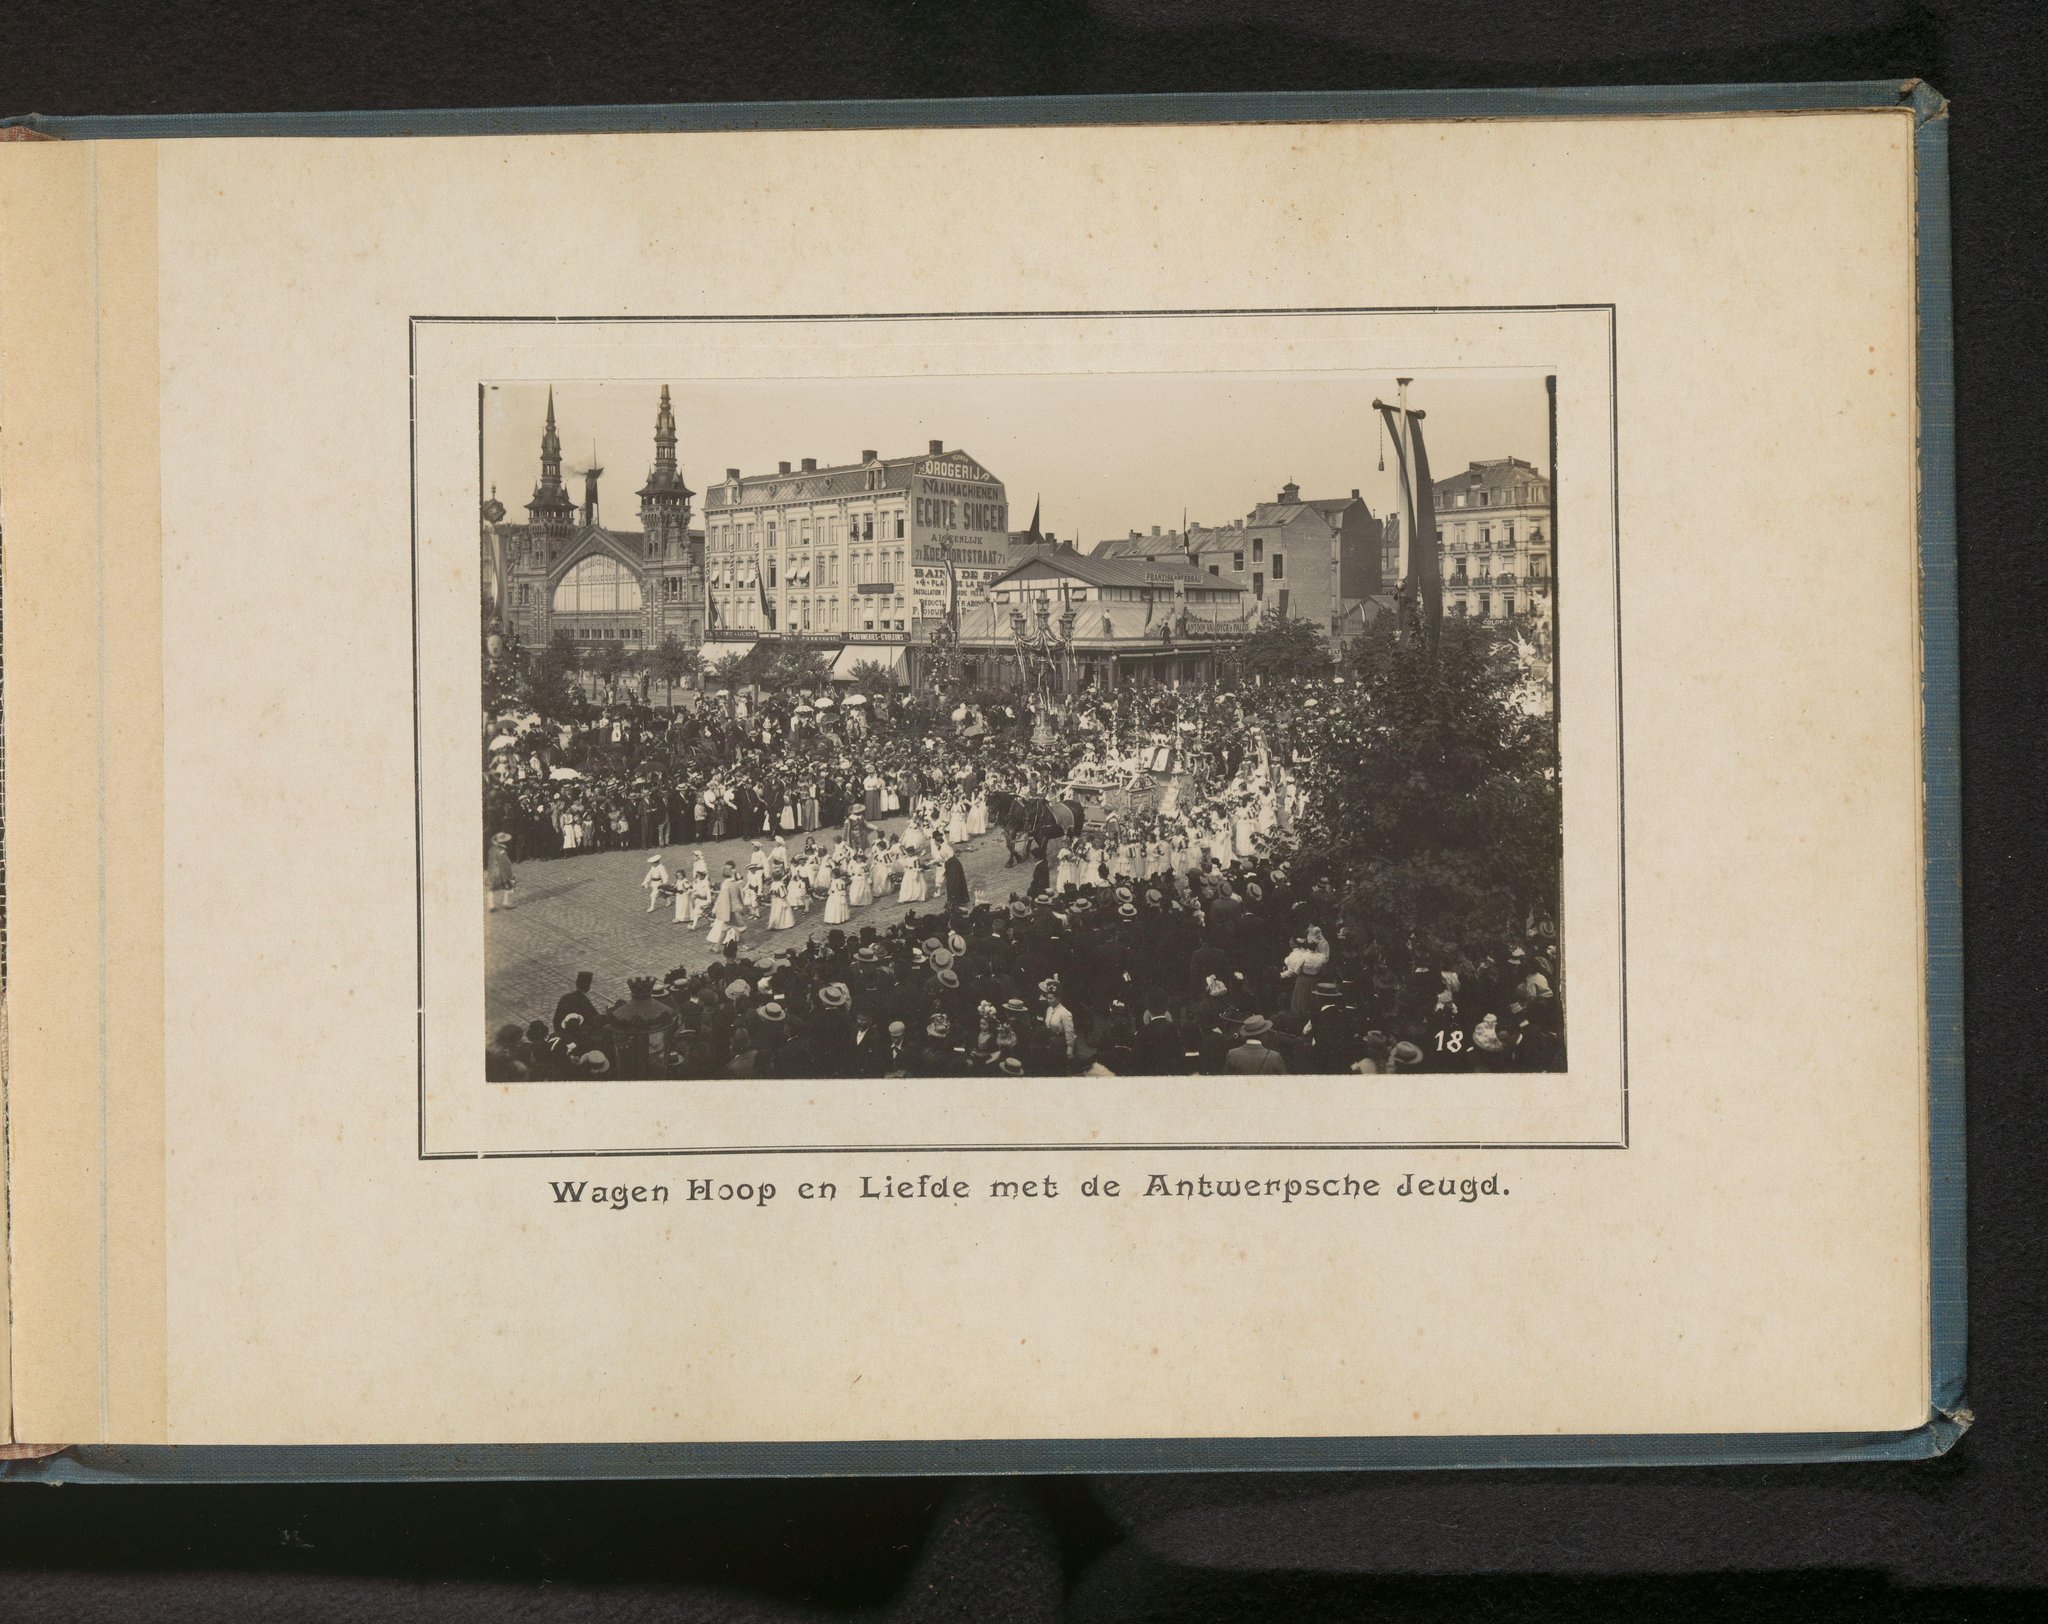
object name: page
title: Wagen Hoop en Liefde met de Antwerpsche jeugd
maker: Anonymous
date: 1899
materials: photographic support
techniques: printing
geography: antwerp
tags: animal traction, animal-drawn vehicle (carriage etc.), festivities (+ decorated float, wagon ~ festive activities), civic architecture; edifices; dwellings, antwerp